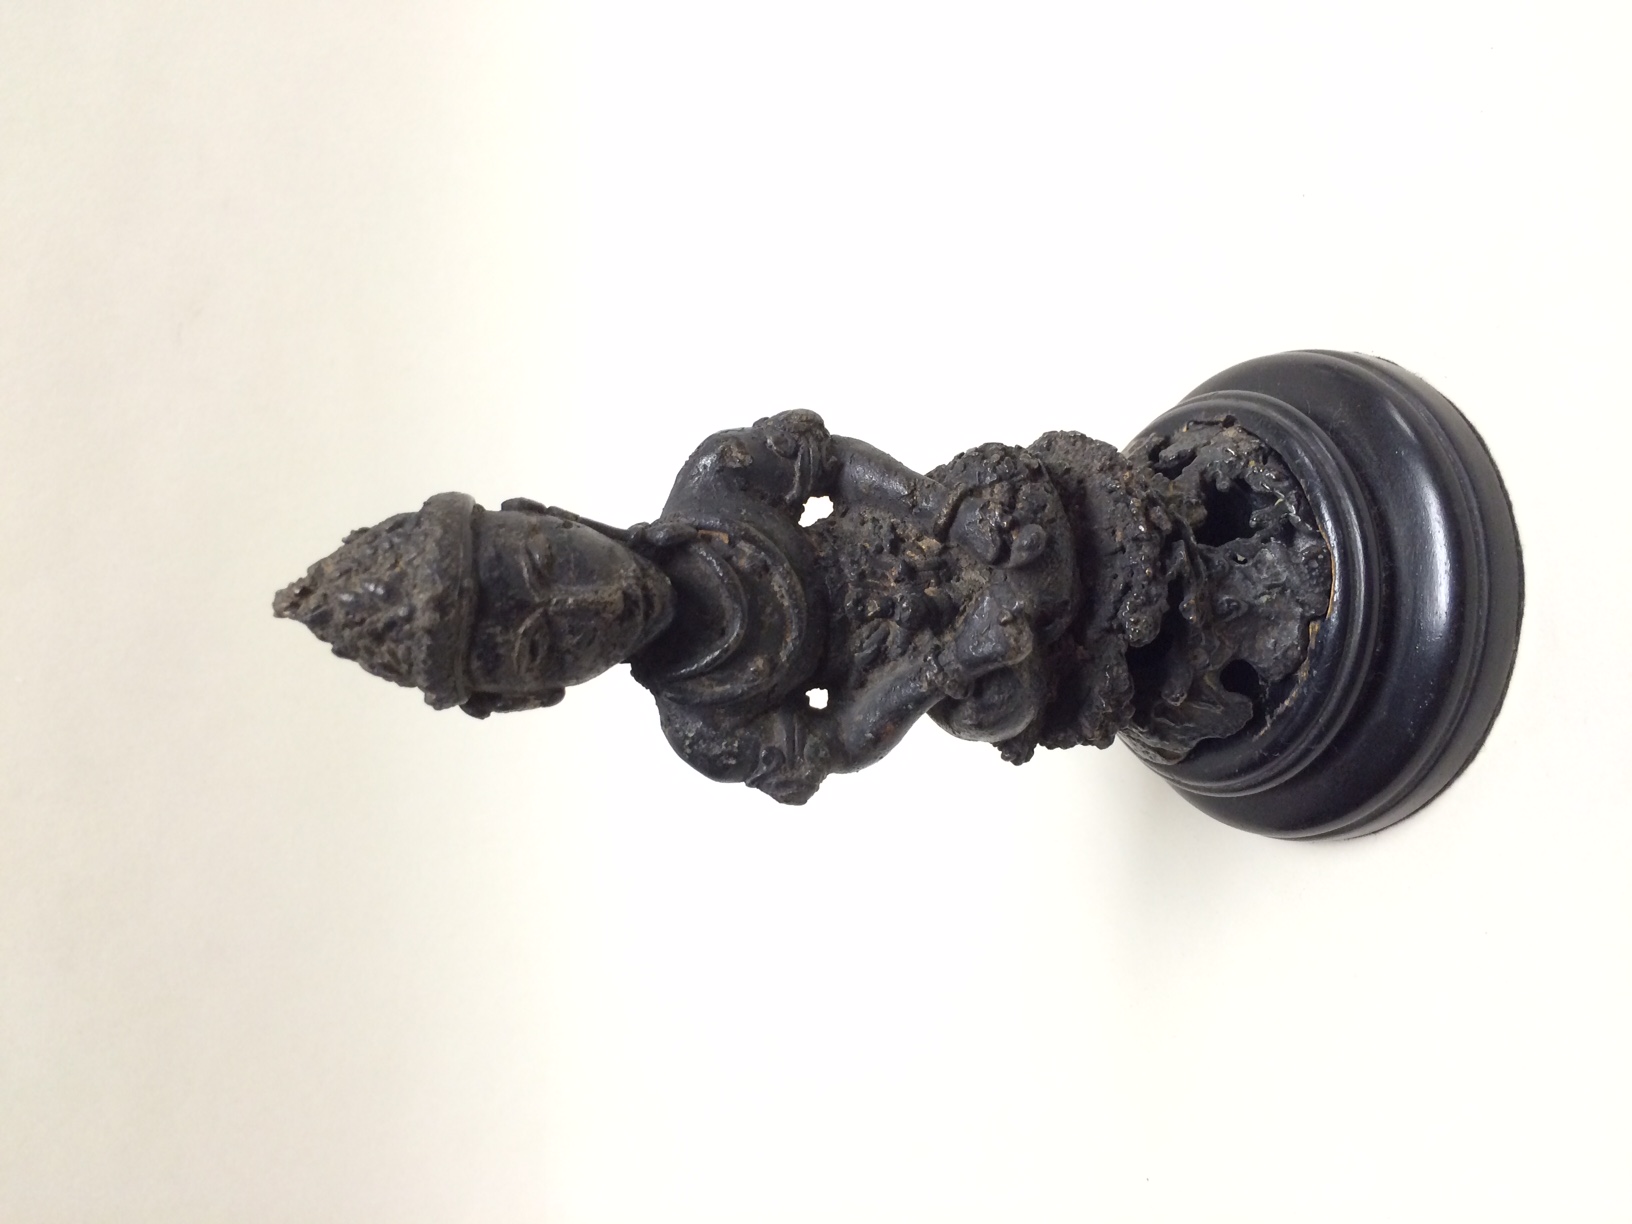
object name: figure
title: Seated Deity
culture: indonesian, javanese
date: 901-1000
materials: bronze